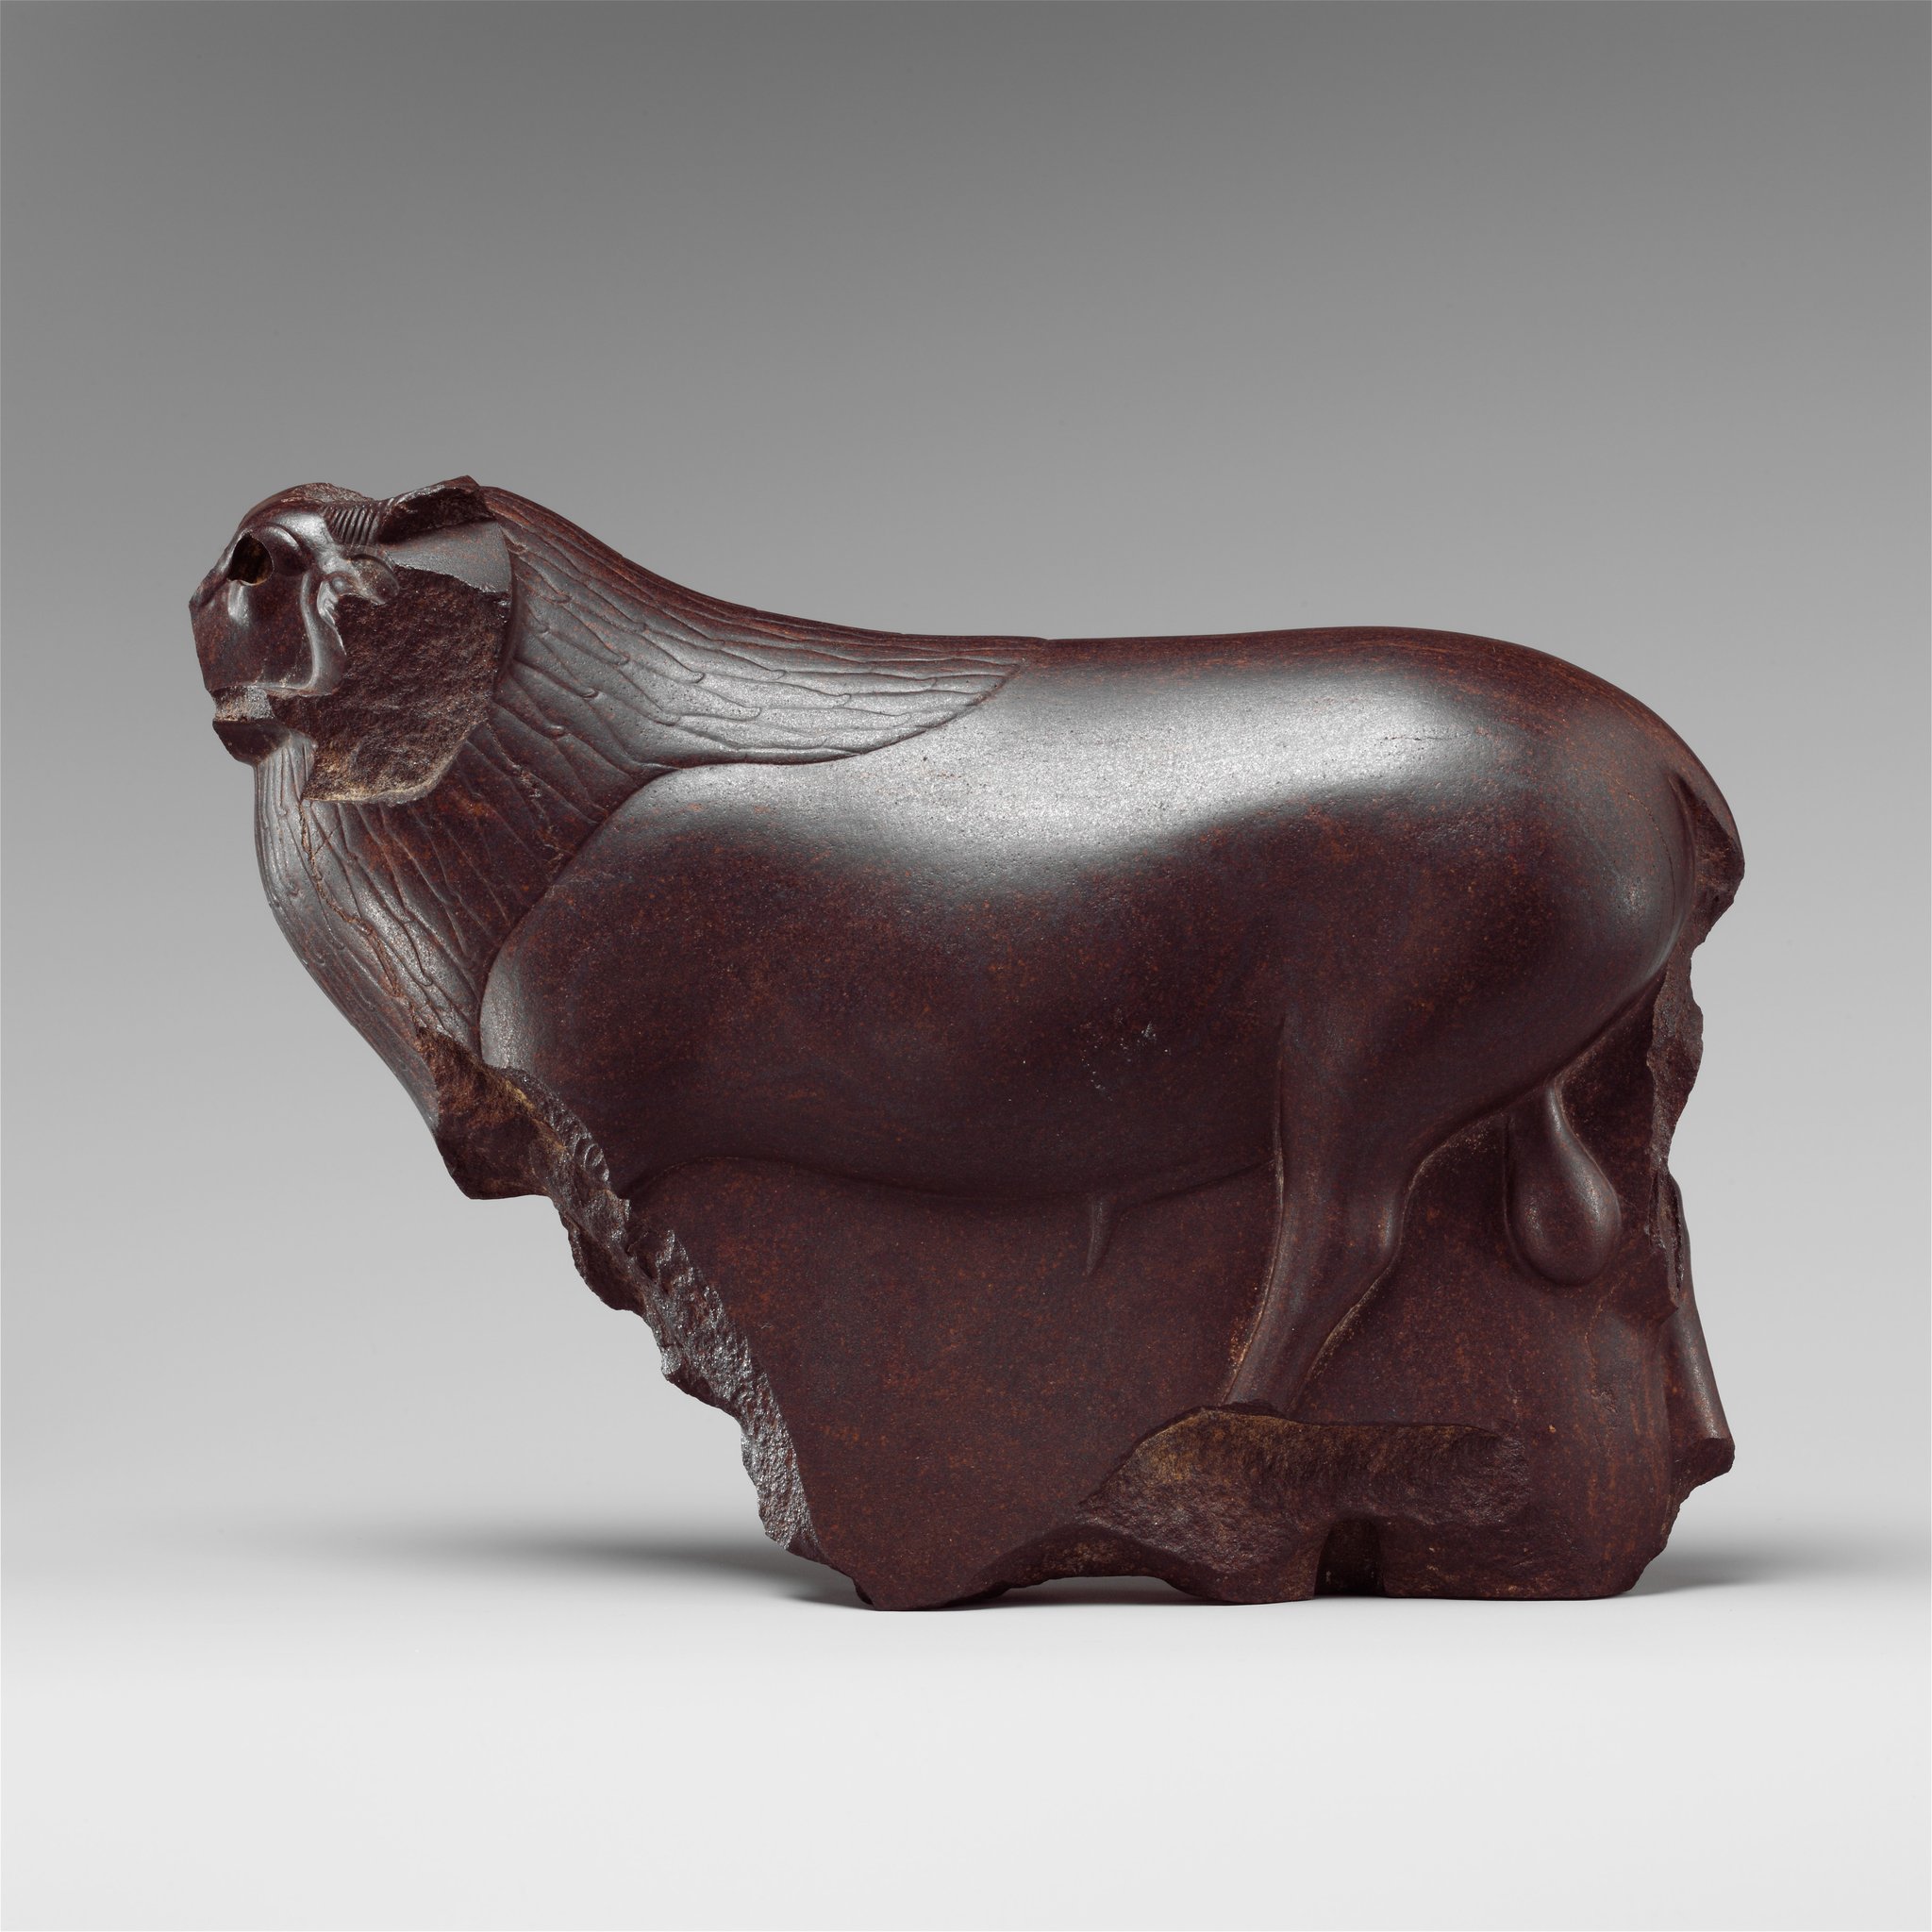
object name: statuette, ram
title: Statuette of a ram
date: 570-300 BCE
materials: stone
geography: egypt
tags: rams